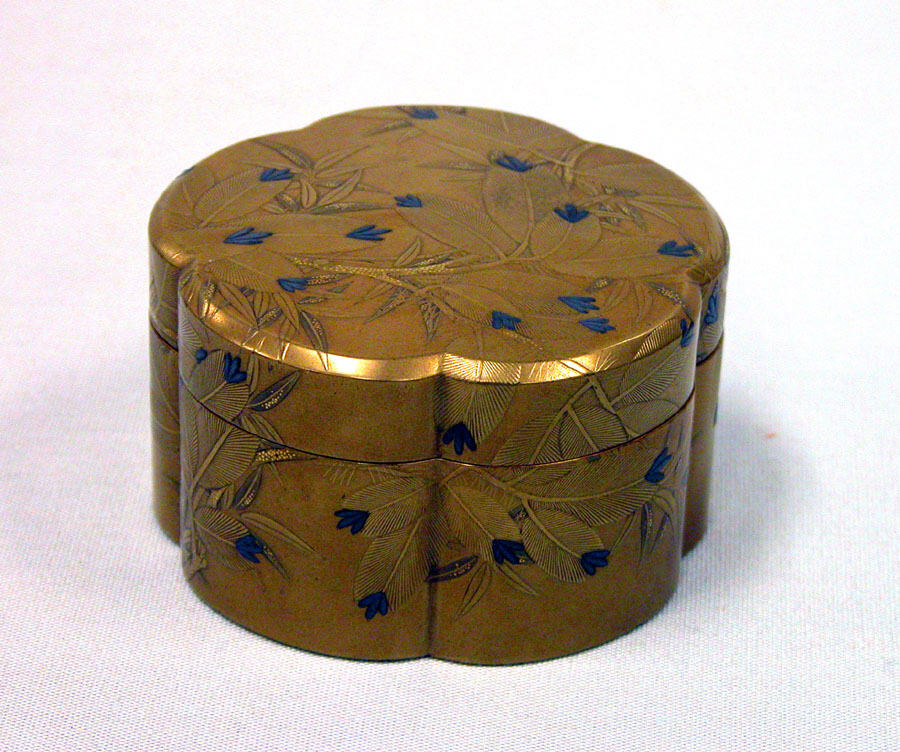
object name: incense box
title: Incense box with pines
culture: japanese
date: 1701-1800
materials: gold, gold foil, gold leaf, silver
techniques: cutting, hiramakie, maki-e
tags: flowers,leaves